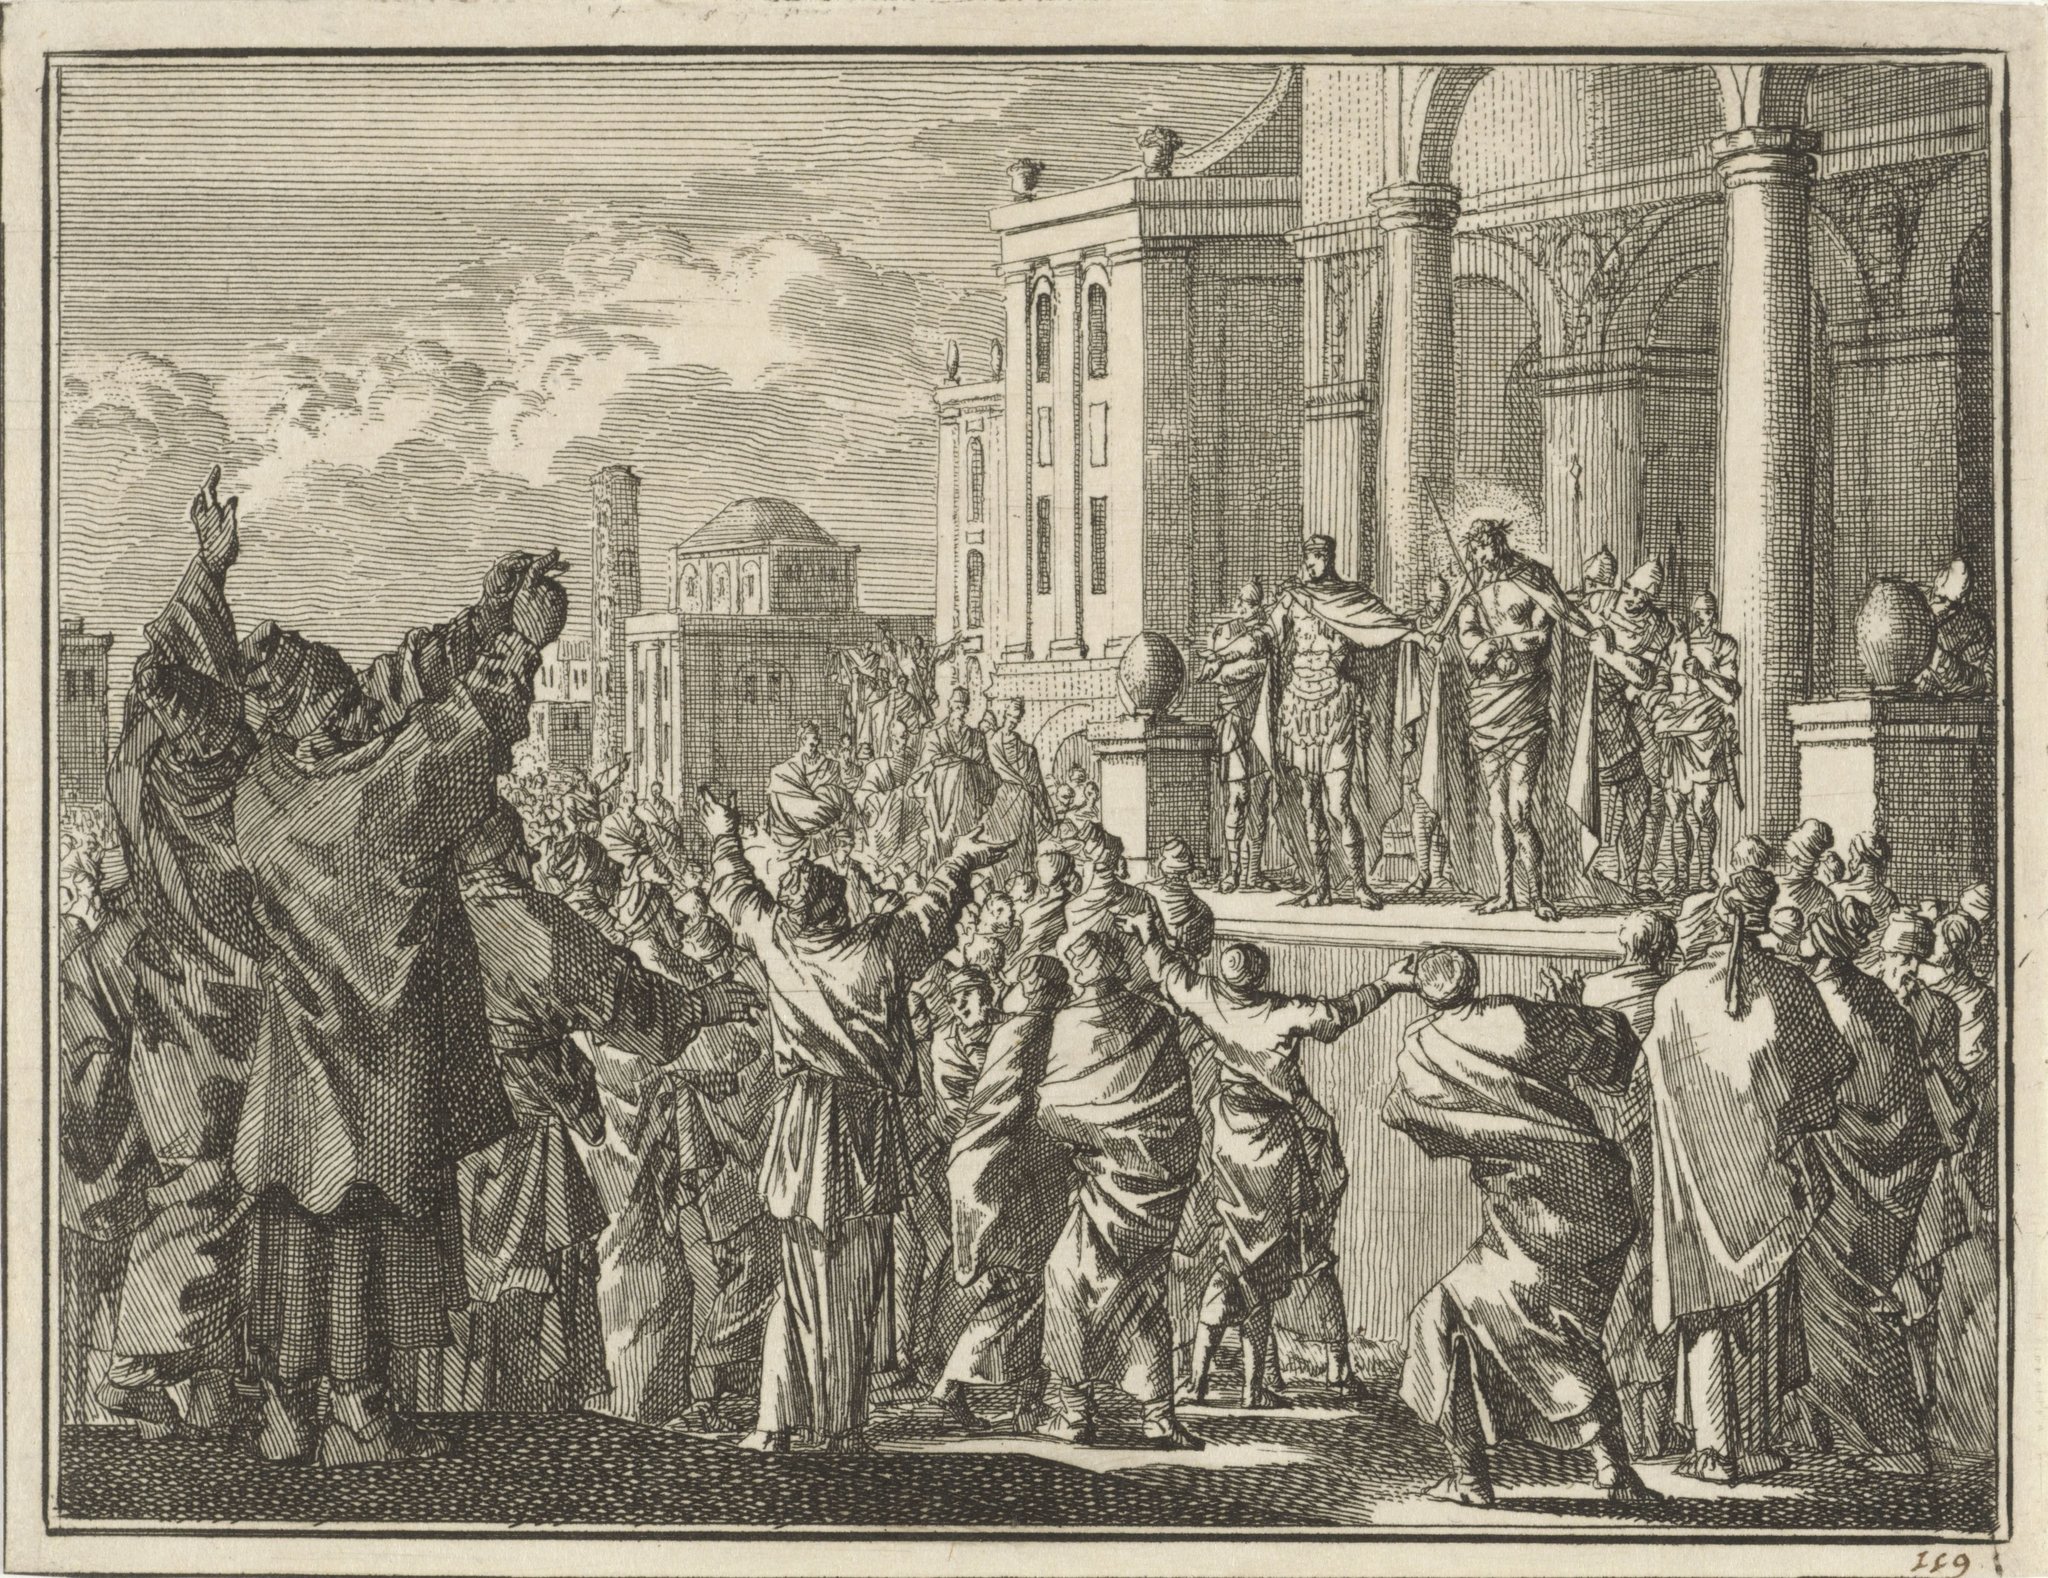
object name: print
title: Christus aan het volk getoond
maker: jan luyken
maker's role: draughtsman, print maker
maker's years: 1649-1712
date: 1712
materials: paper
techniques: etching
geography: amsterdam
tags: pilate showing christ to the people, 'ostentatio christi', 'ecce homo' (john 19:4-6)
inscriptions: collector's mark: Lugt 2228, number: ‘119’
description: Proefdruk van illustratie uit: Luyken, Jan. De schriftuurlyke geschiedenissen en gelykenissen van het Oude en Nieuwe Verbond, 2 delen. Amsterdam: Wed. Pieter Arentsz II en Cornelis van der Sys, 1712, dl. II.